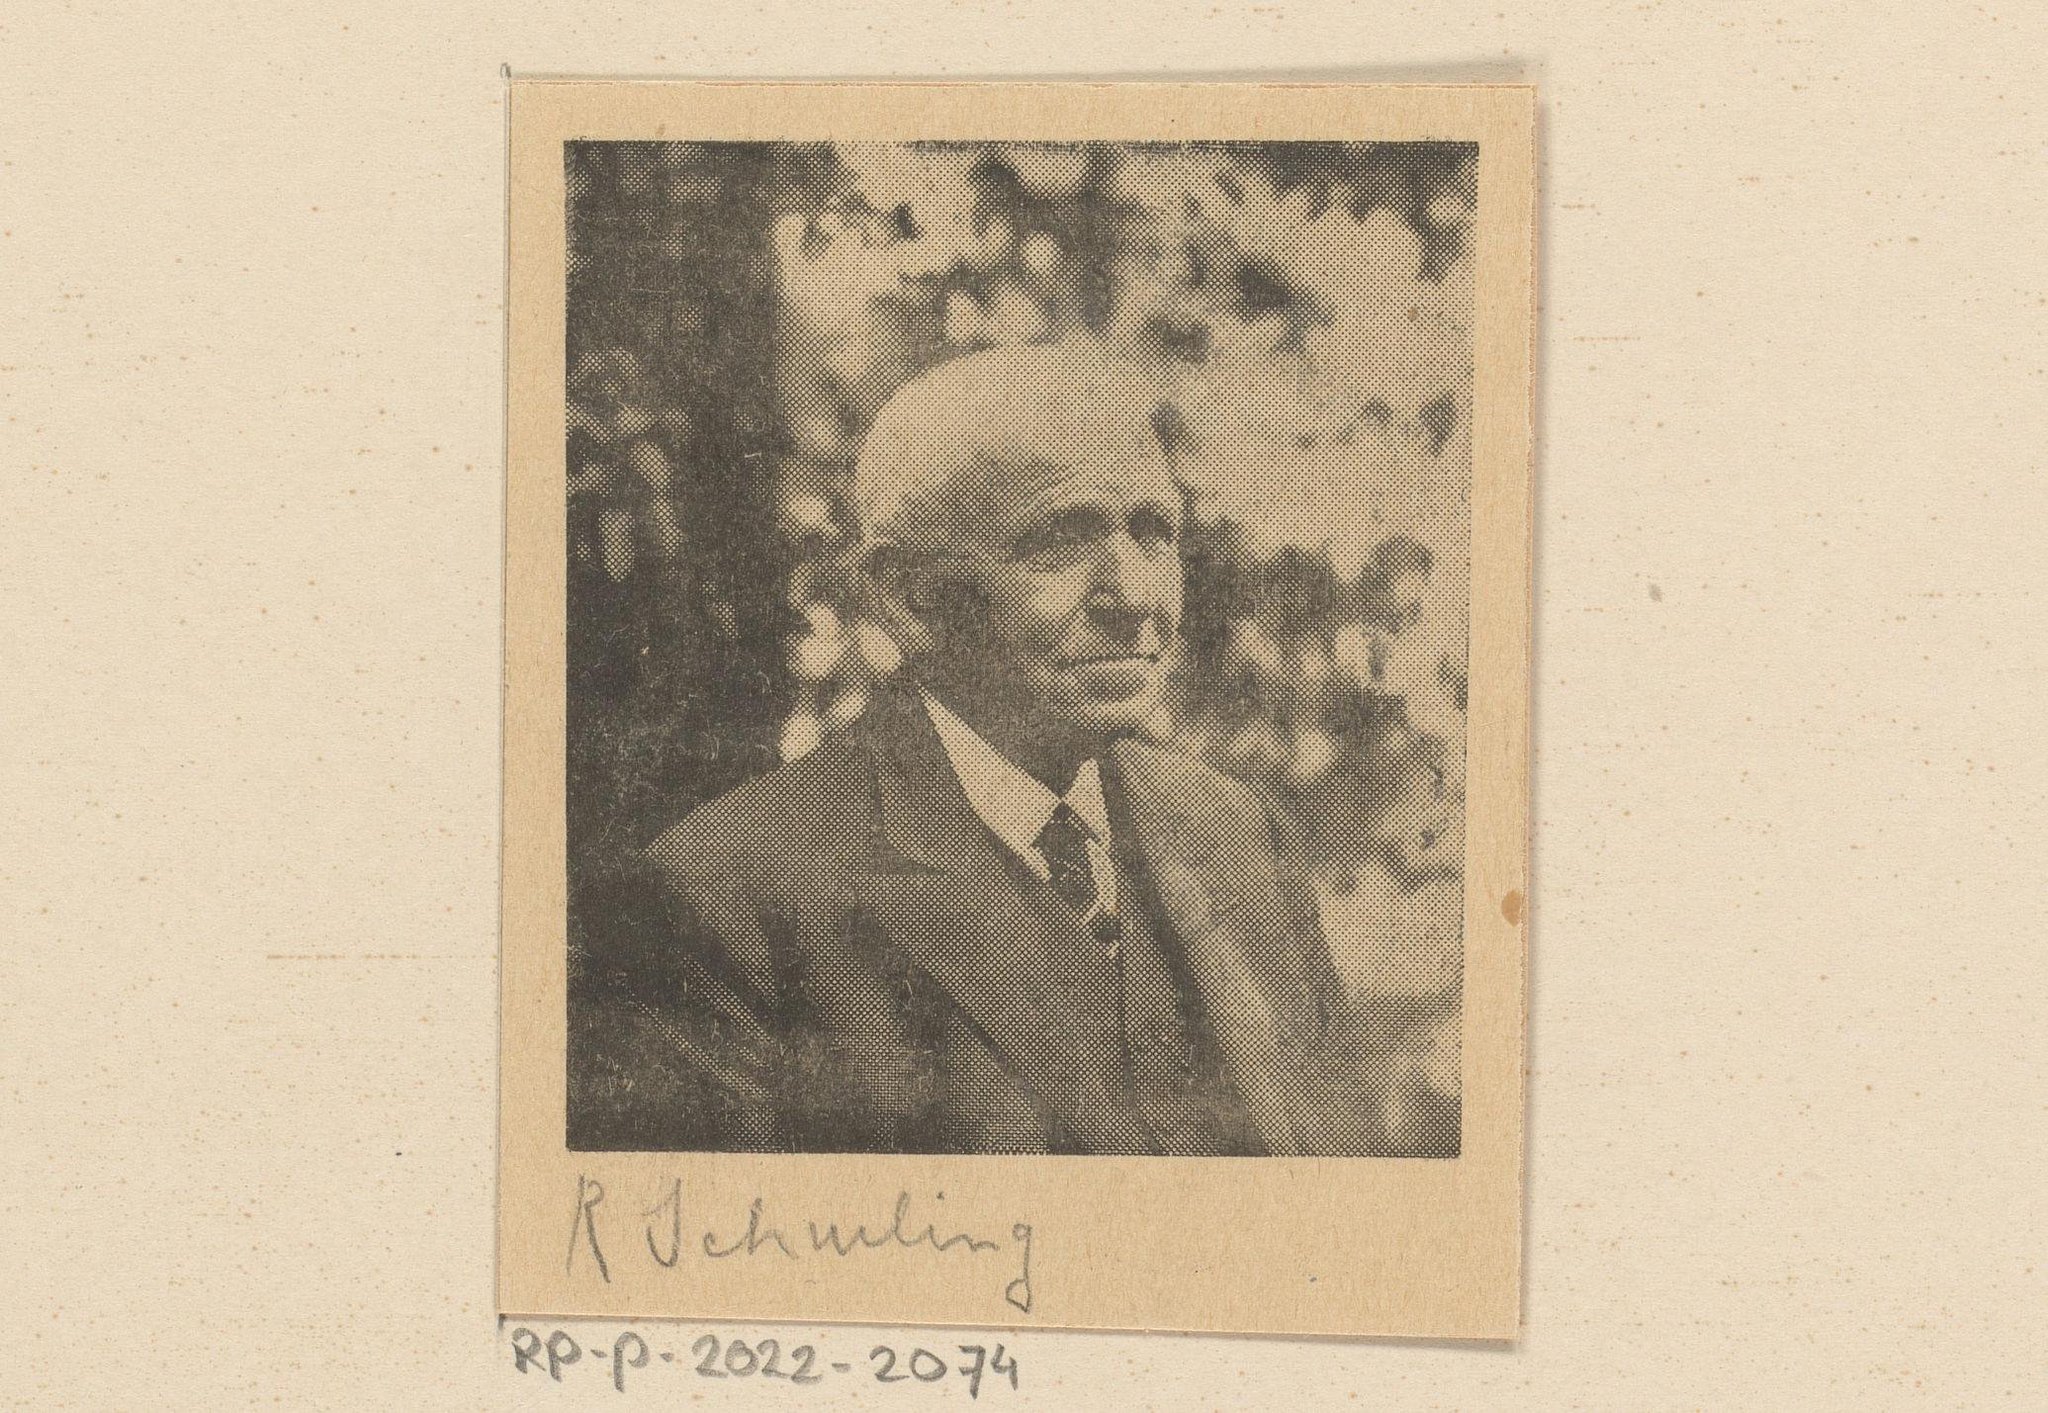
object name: photomechanical print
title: Portret van Roelof Schuiling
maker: Anonymous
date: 1924-1970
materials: paper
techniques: autotype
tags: historical persons, scholastic education, tuition (+ teacher, professor)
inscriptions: name: ‘R Schuiling’